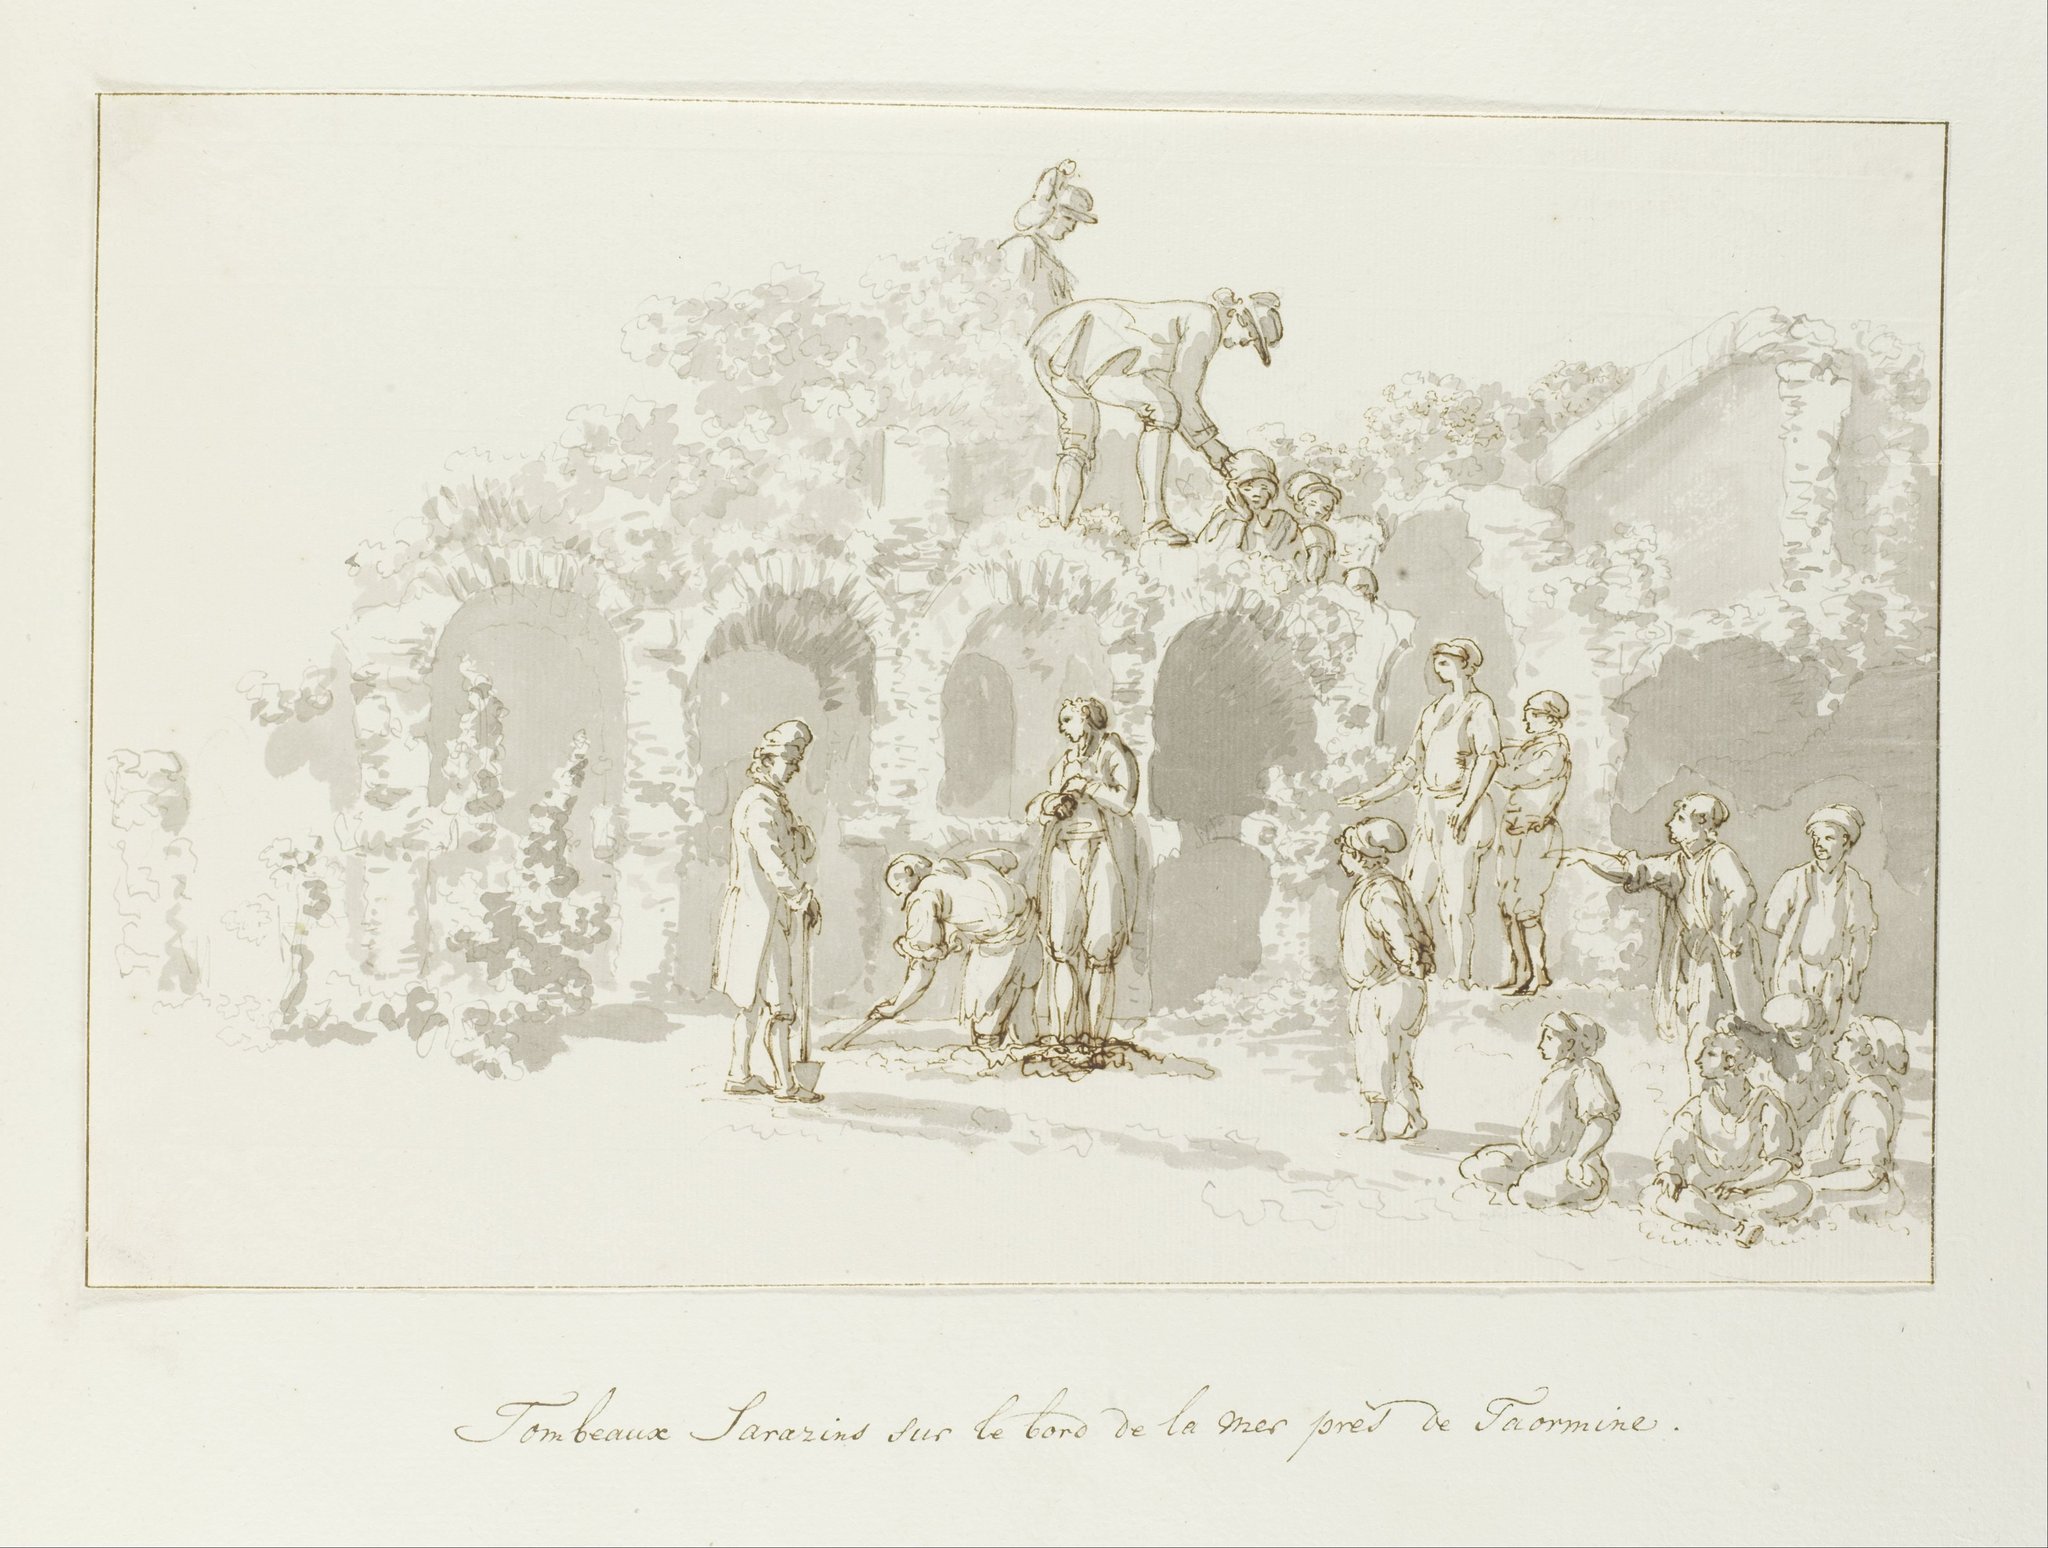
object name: drawing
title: Tombeaux Srazins sur le bord de la mer près de Tavormine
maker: louis ducros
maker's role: draughtsman, print maker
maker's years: 1748-1810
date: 1778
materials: paper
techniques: brush, pen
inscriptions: number: ‘No 157 Tombeaux Srazins sur le bord de la mer près de Tavormine’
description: Tekening uit het album 'Voyage en Italie, en Sicile et à Malte', 1778.